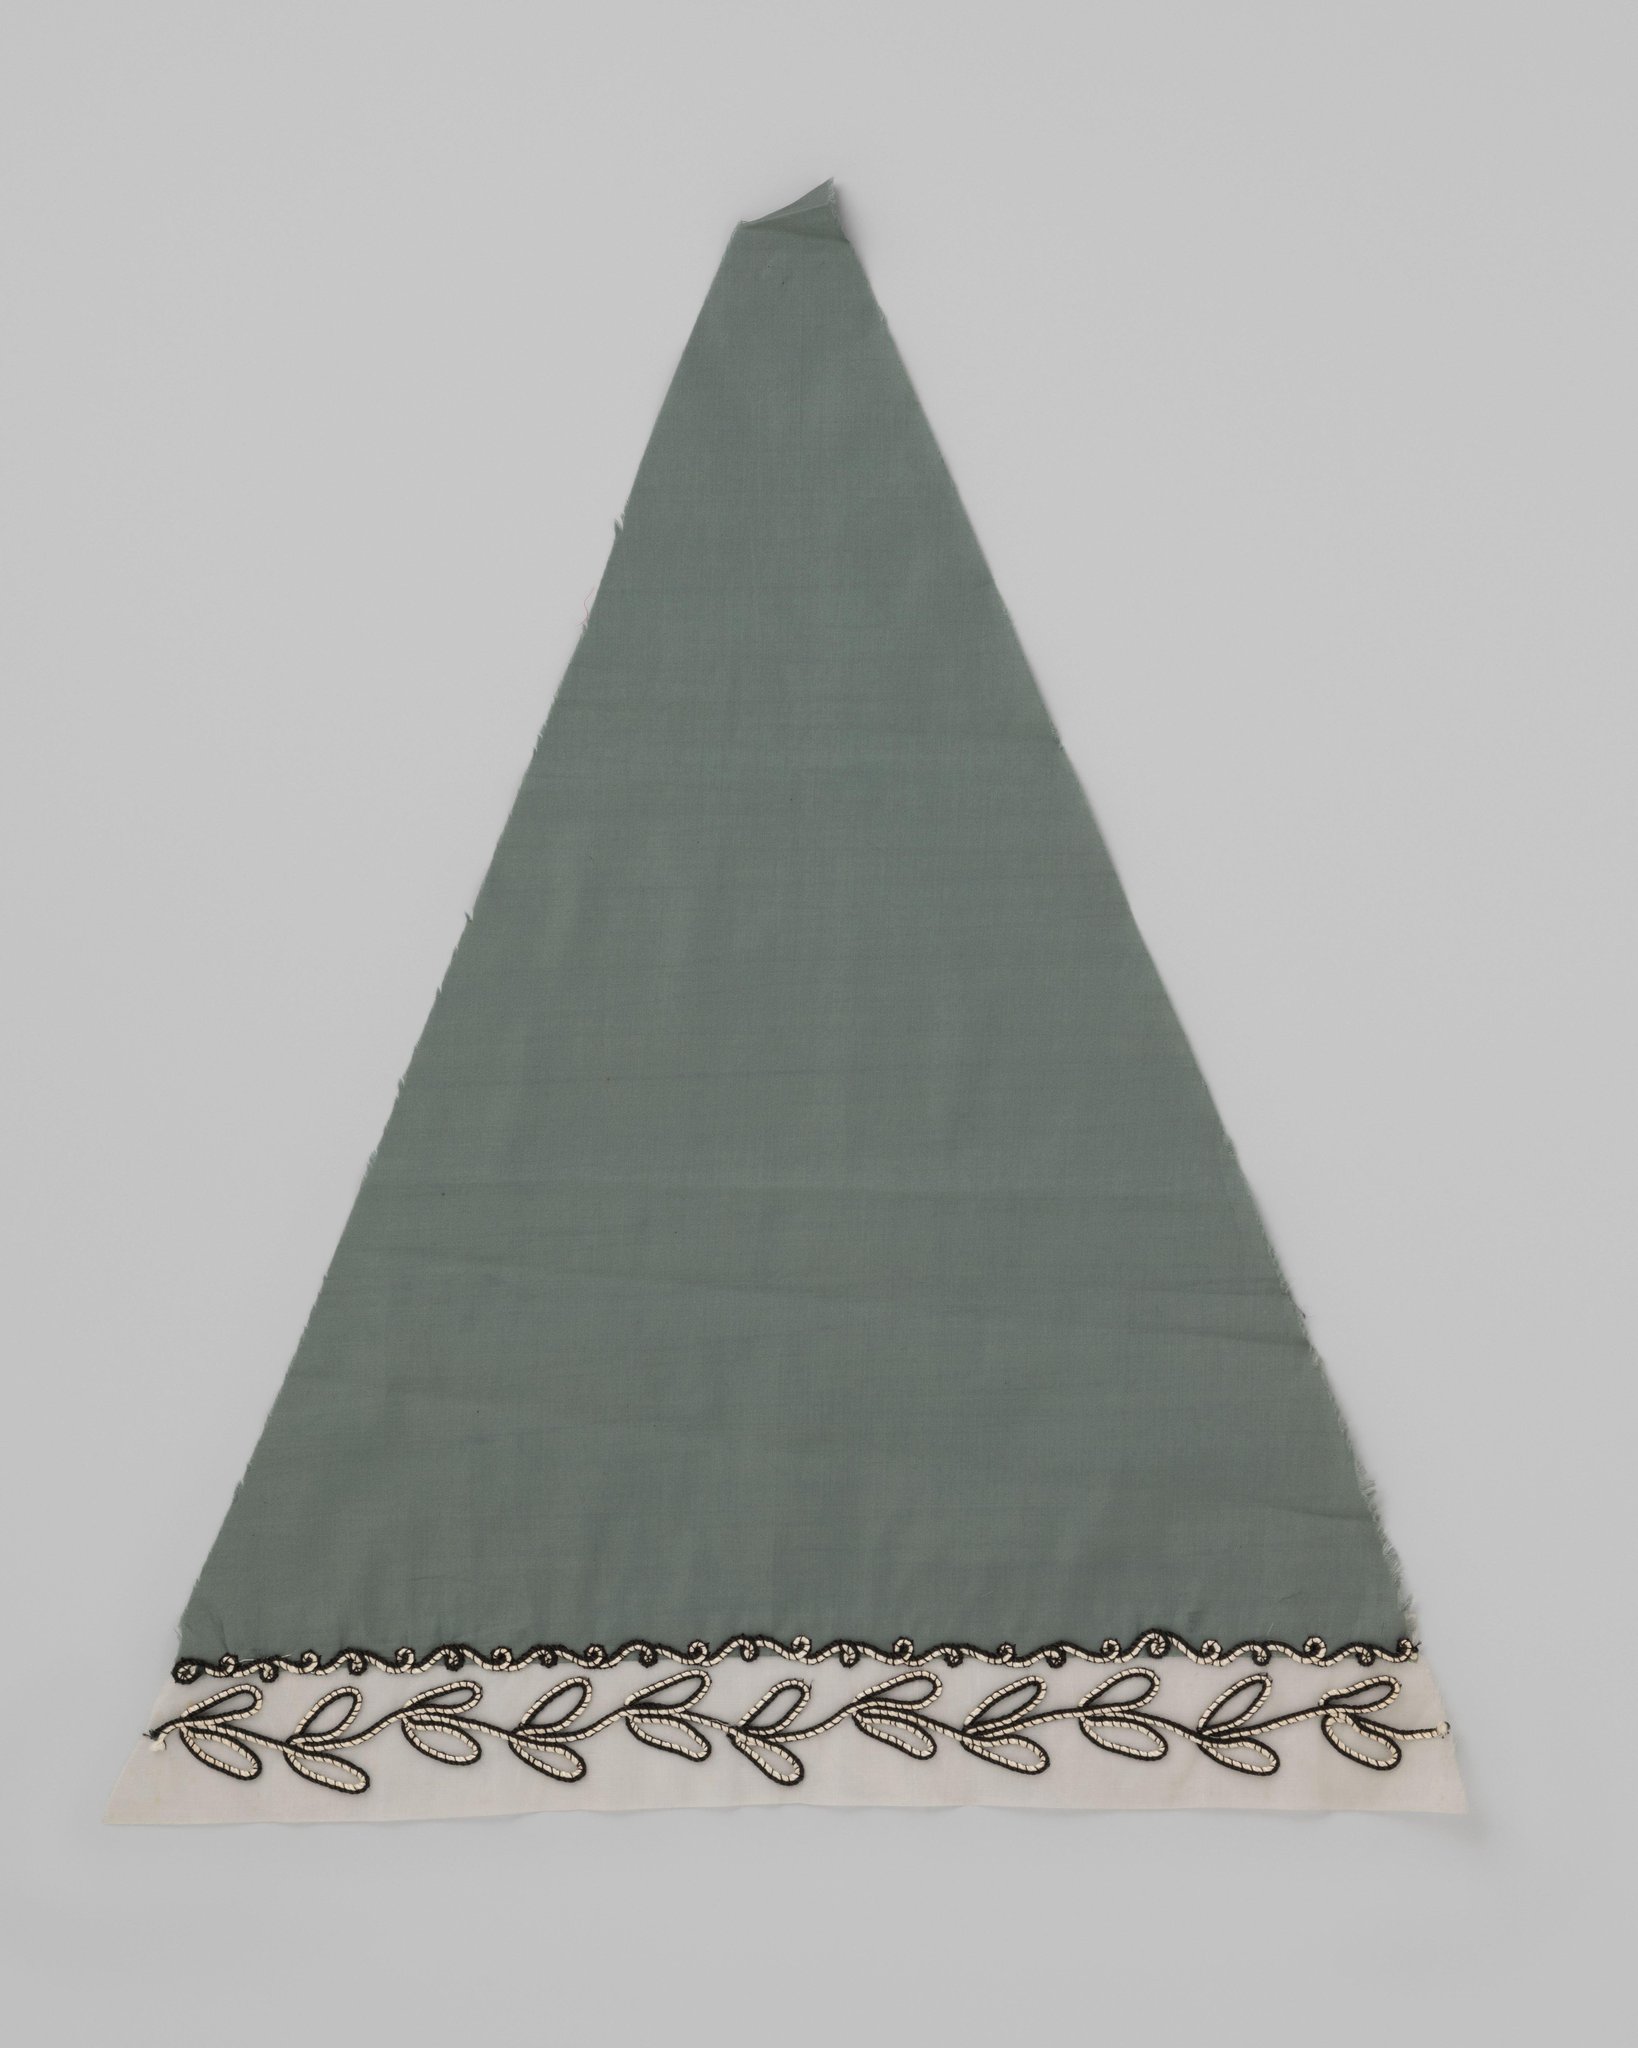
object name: parasoldek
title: Sector van een parasoldek van zachtgroene katoen, met een met woldraad geborduurde batisten rand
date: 1885-1900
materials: cotton, wool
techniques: embroidered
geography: nijmegen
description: Sector van een parasoldek van zachtgroene katoen, met een met woldraad geborduurde batisten rand.